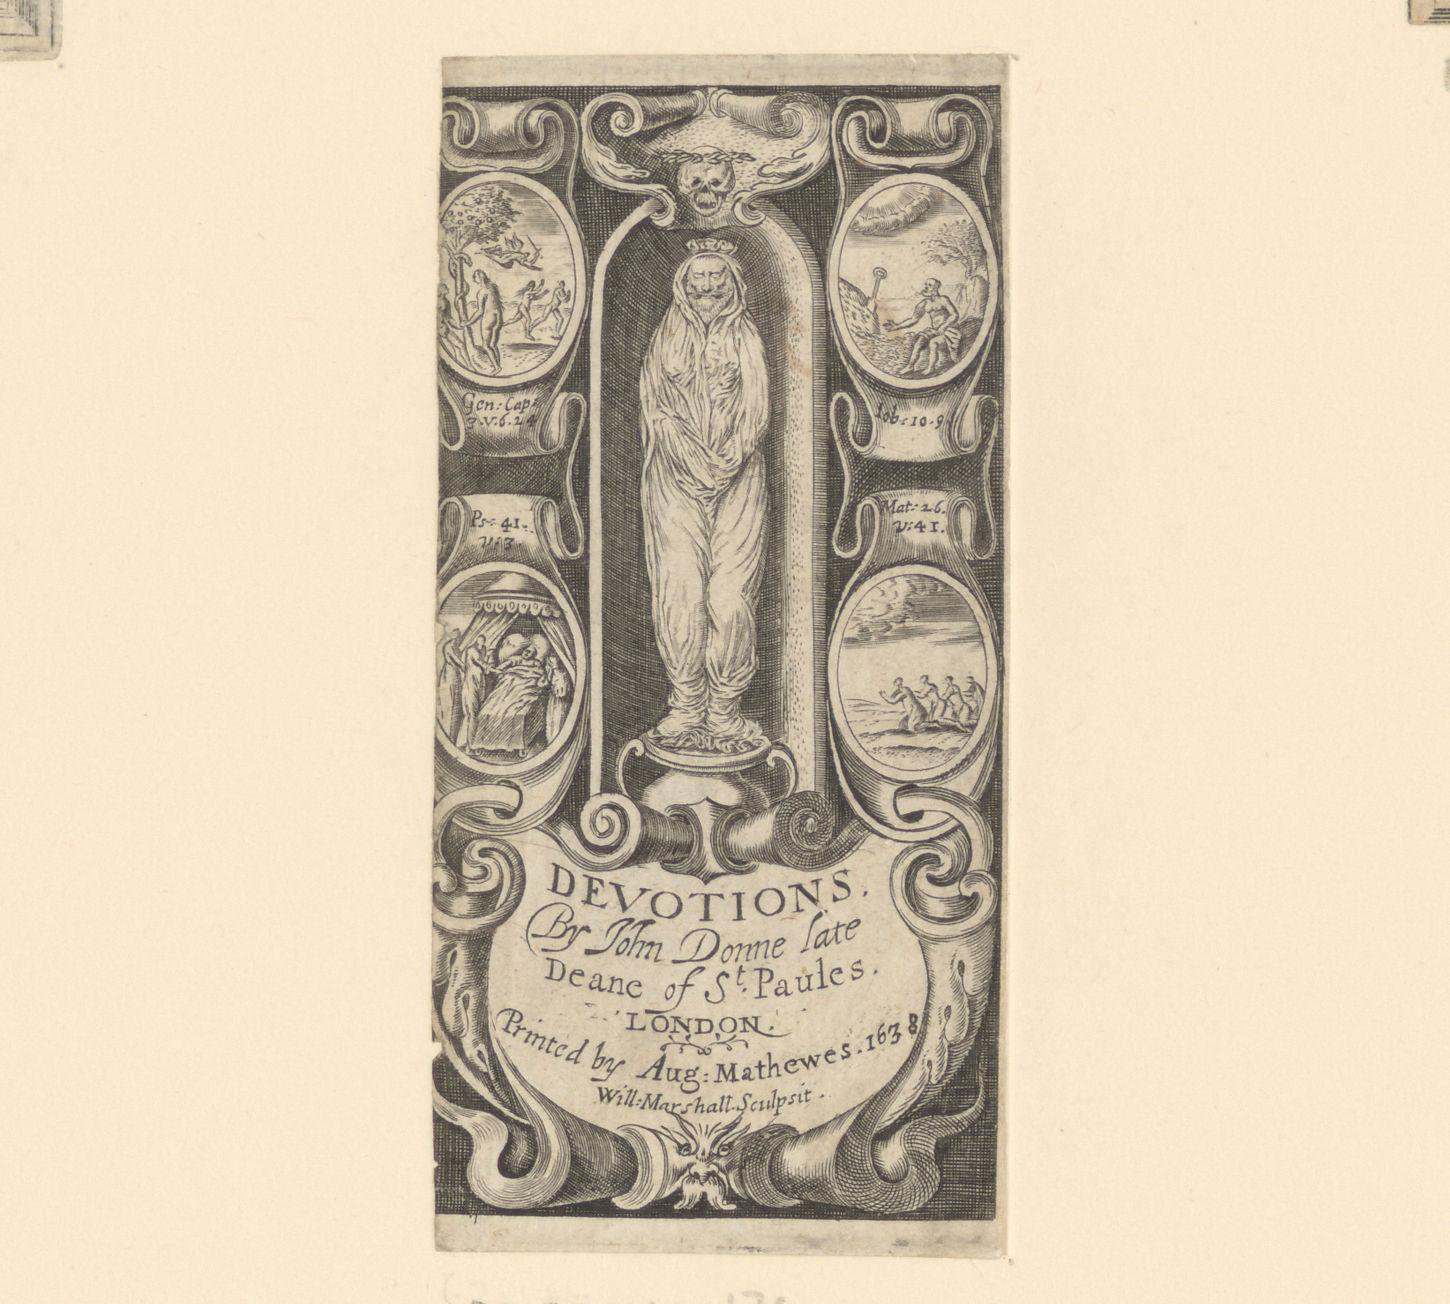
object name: titelblad, titelpagina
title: Vier Bijbelpassages rondom een in doeken gewikkelde man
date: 1638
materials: paper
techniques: engraving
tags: gethsemane, mount of olives, 'oelberg' (matthew 26:36-56; mark 14:32-52; luke 22:39-53; john 18:1-12), expulsion of adam and eve from paradise (genesis 3:22-24), the book of job, the book of psalms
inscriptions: collector's mark: Lugt 2760, collector's mark: Lugt 151, collector's mark: Lugt 2228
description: Tekst in het Engels in de cartouche. De verbeelde Bijbelpassages zijn Gen. 3:6-24, Job 10:9, Psalm 41:3 en Math. 26:41.